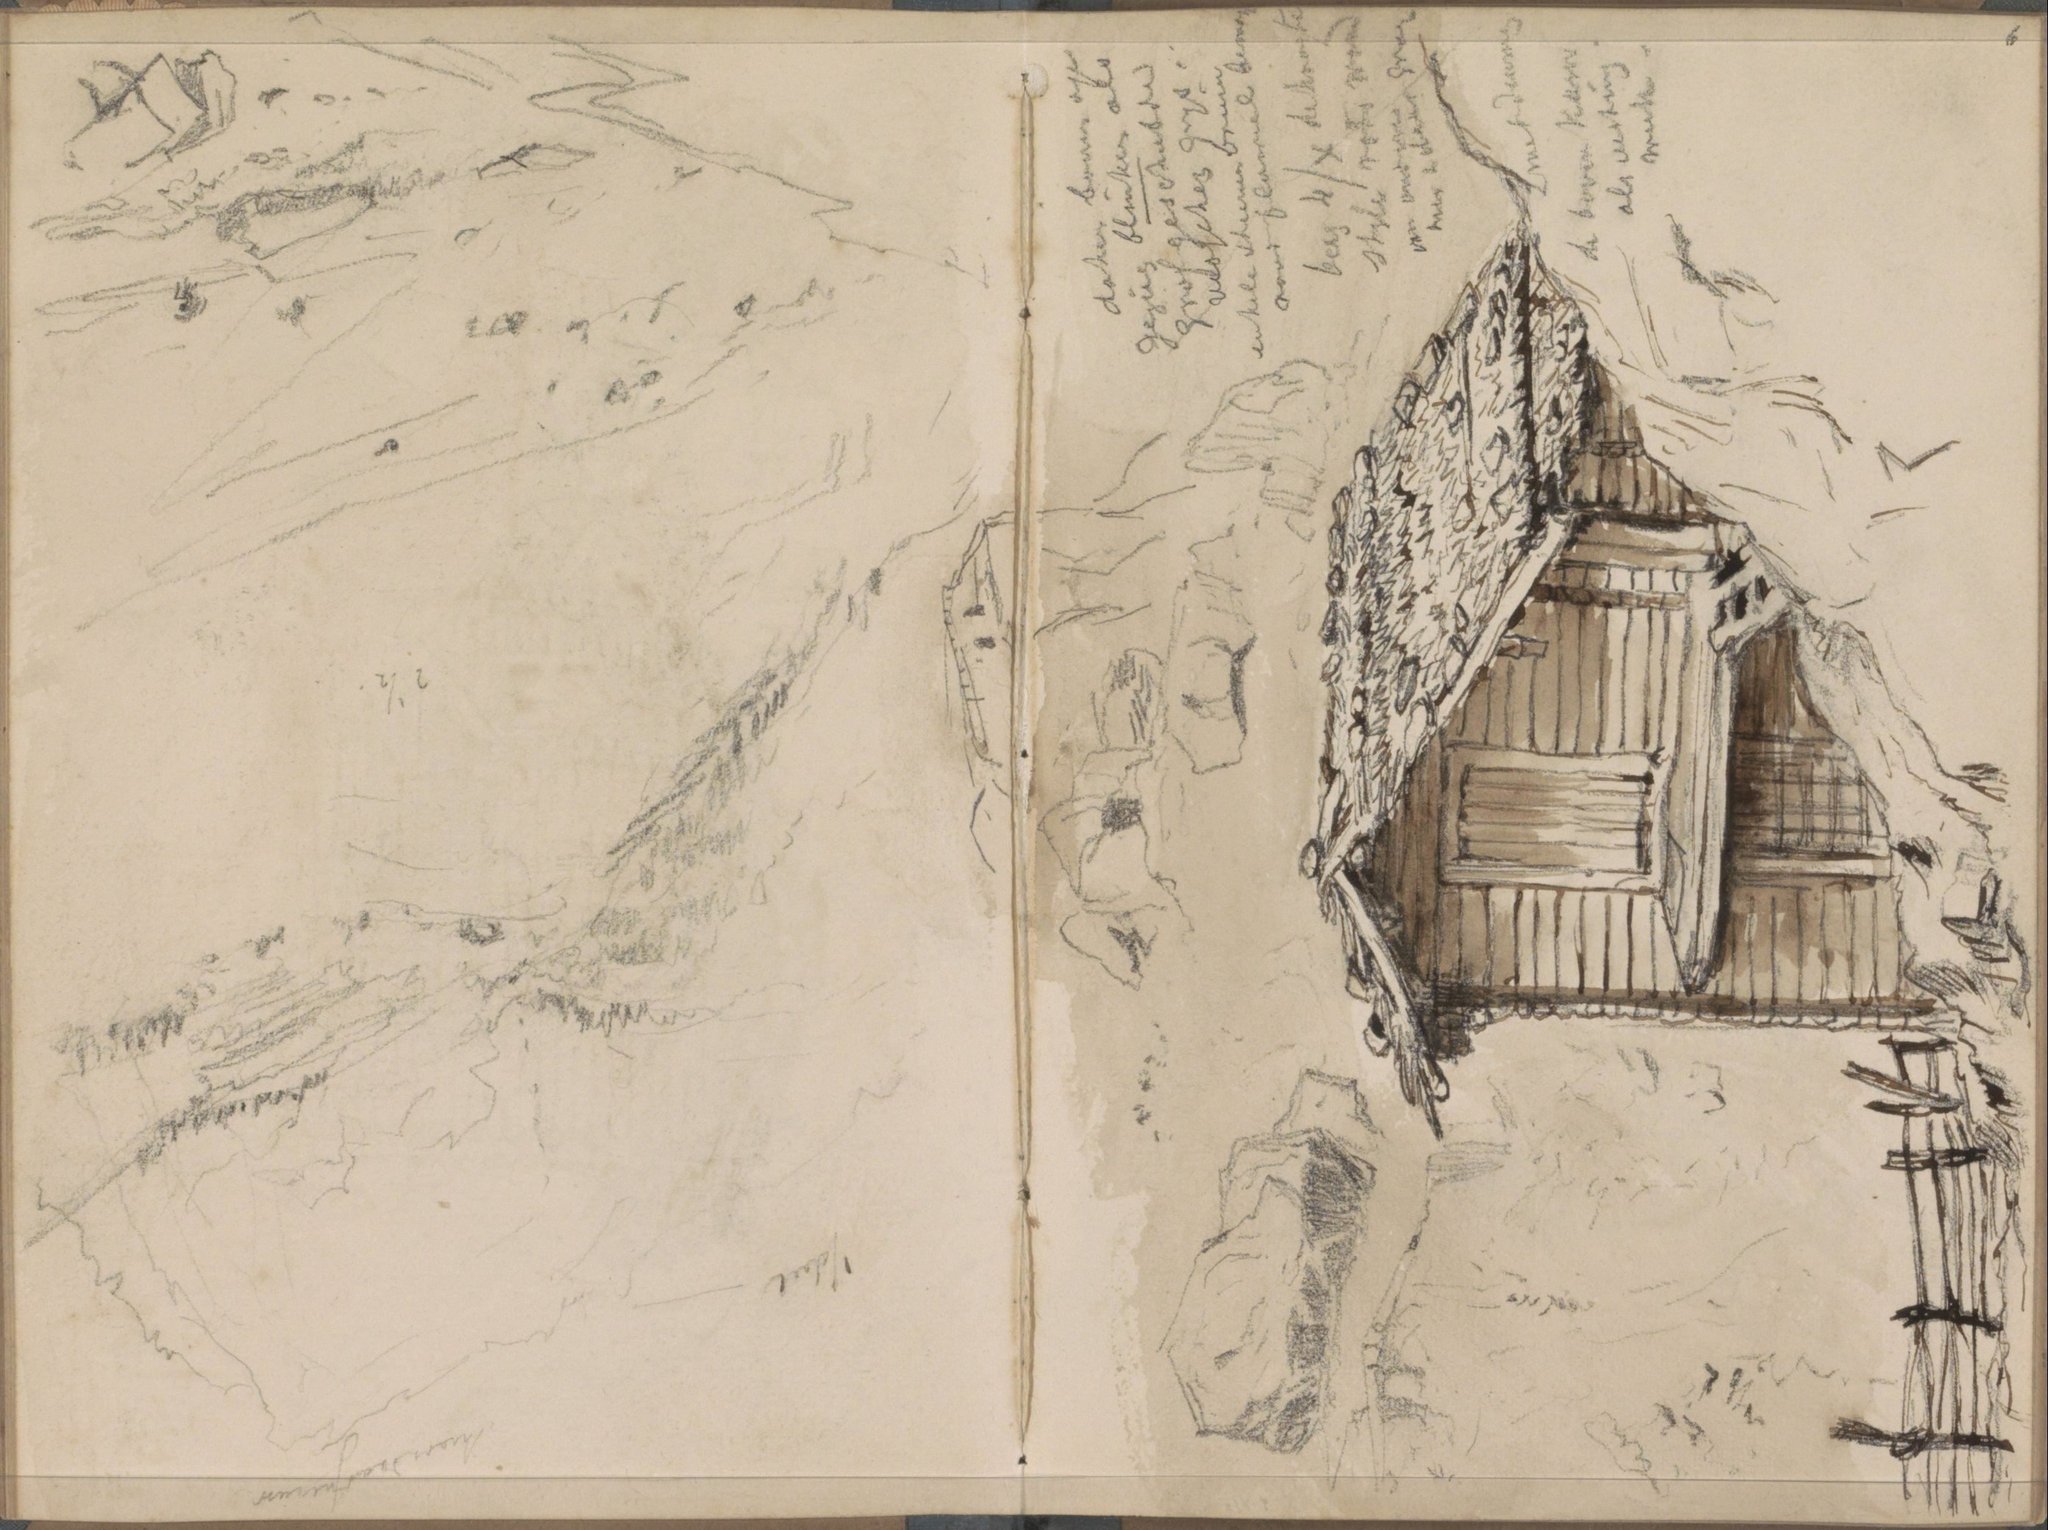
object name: sketchbook leaf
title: Berghut in Tirol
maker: johannes tavenraat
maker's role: draughtsman, painter, print maker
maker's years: 1809-1881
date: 1808-1858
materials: ink, paper, pencil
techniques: brush, pen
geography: tirol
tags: mountain-range, snow peaks, hut, cabin, lodge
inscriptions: kleurnotitie, handgeschreven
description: Blad 5 verso en 6 recto uit een schetsboek met 47 bladen.